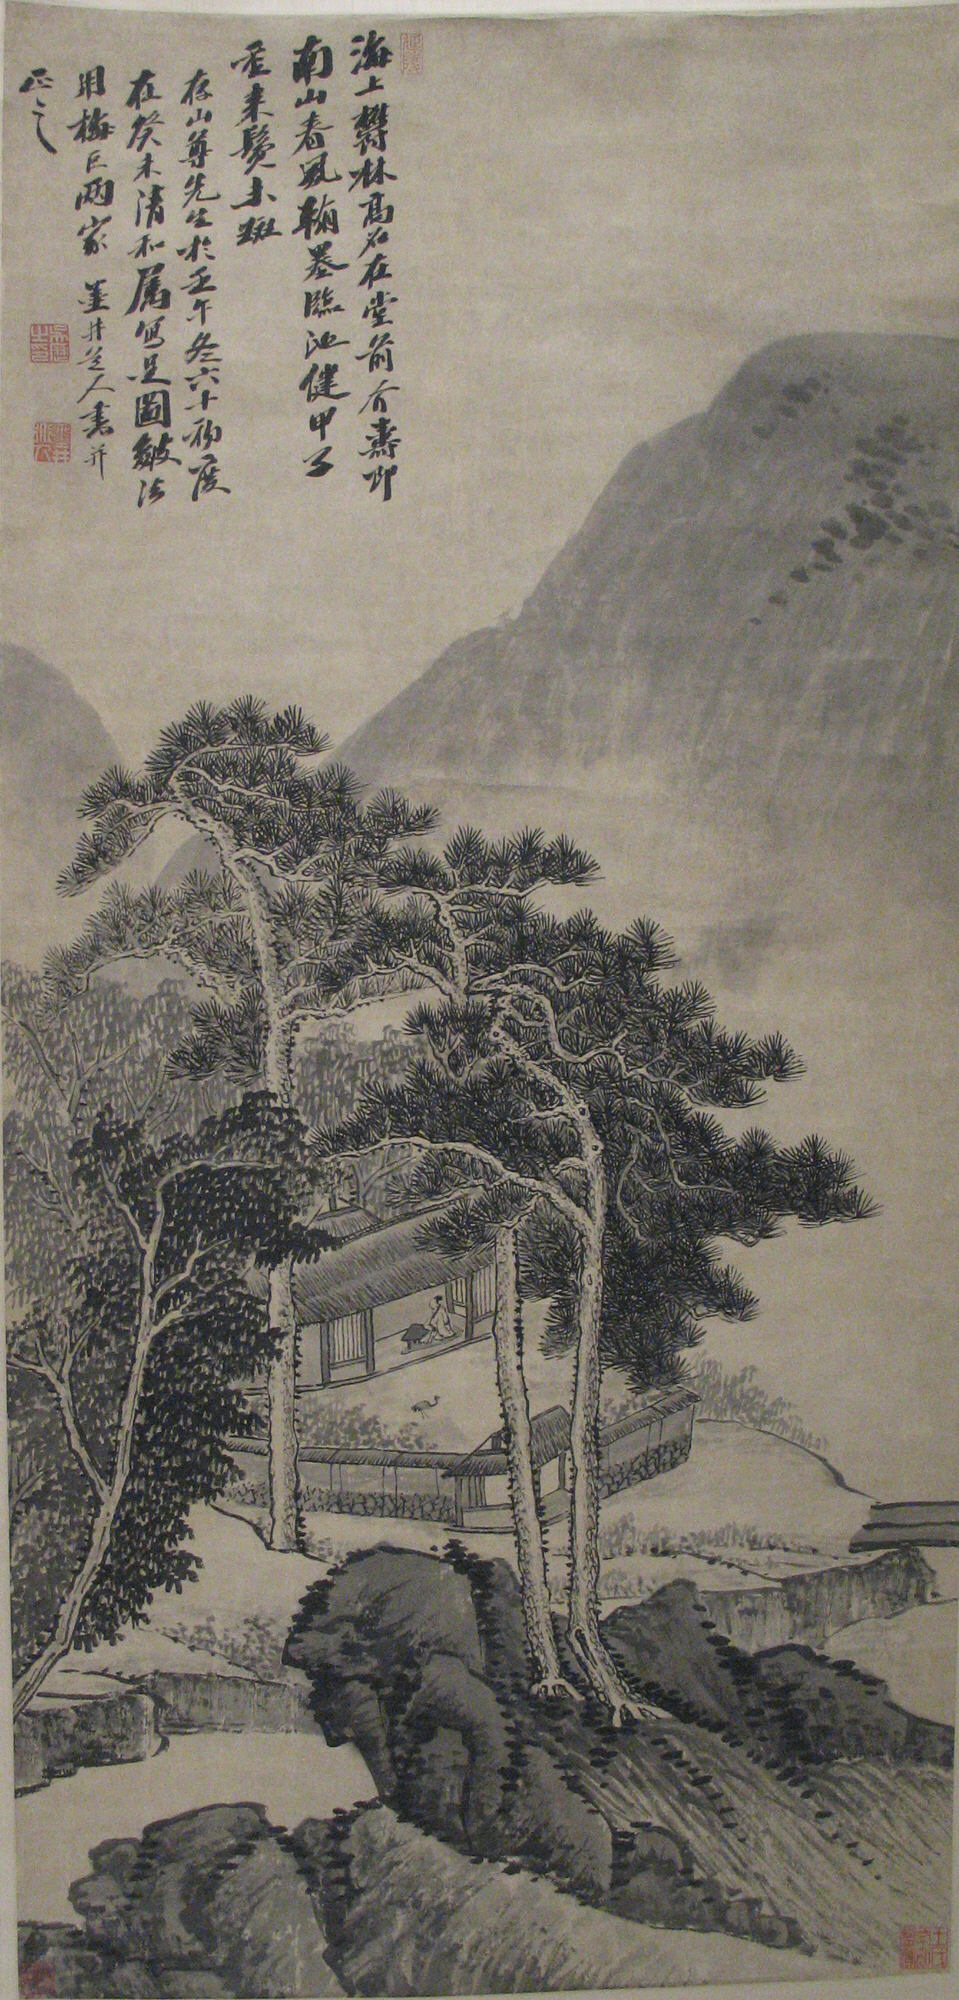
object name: hanging scroll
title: A Lodge in the Hills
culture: chinese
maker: wu li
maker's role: artist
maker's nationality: chinese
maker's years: 1632-1718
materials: ink, paper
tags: hills,landscapes